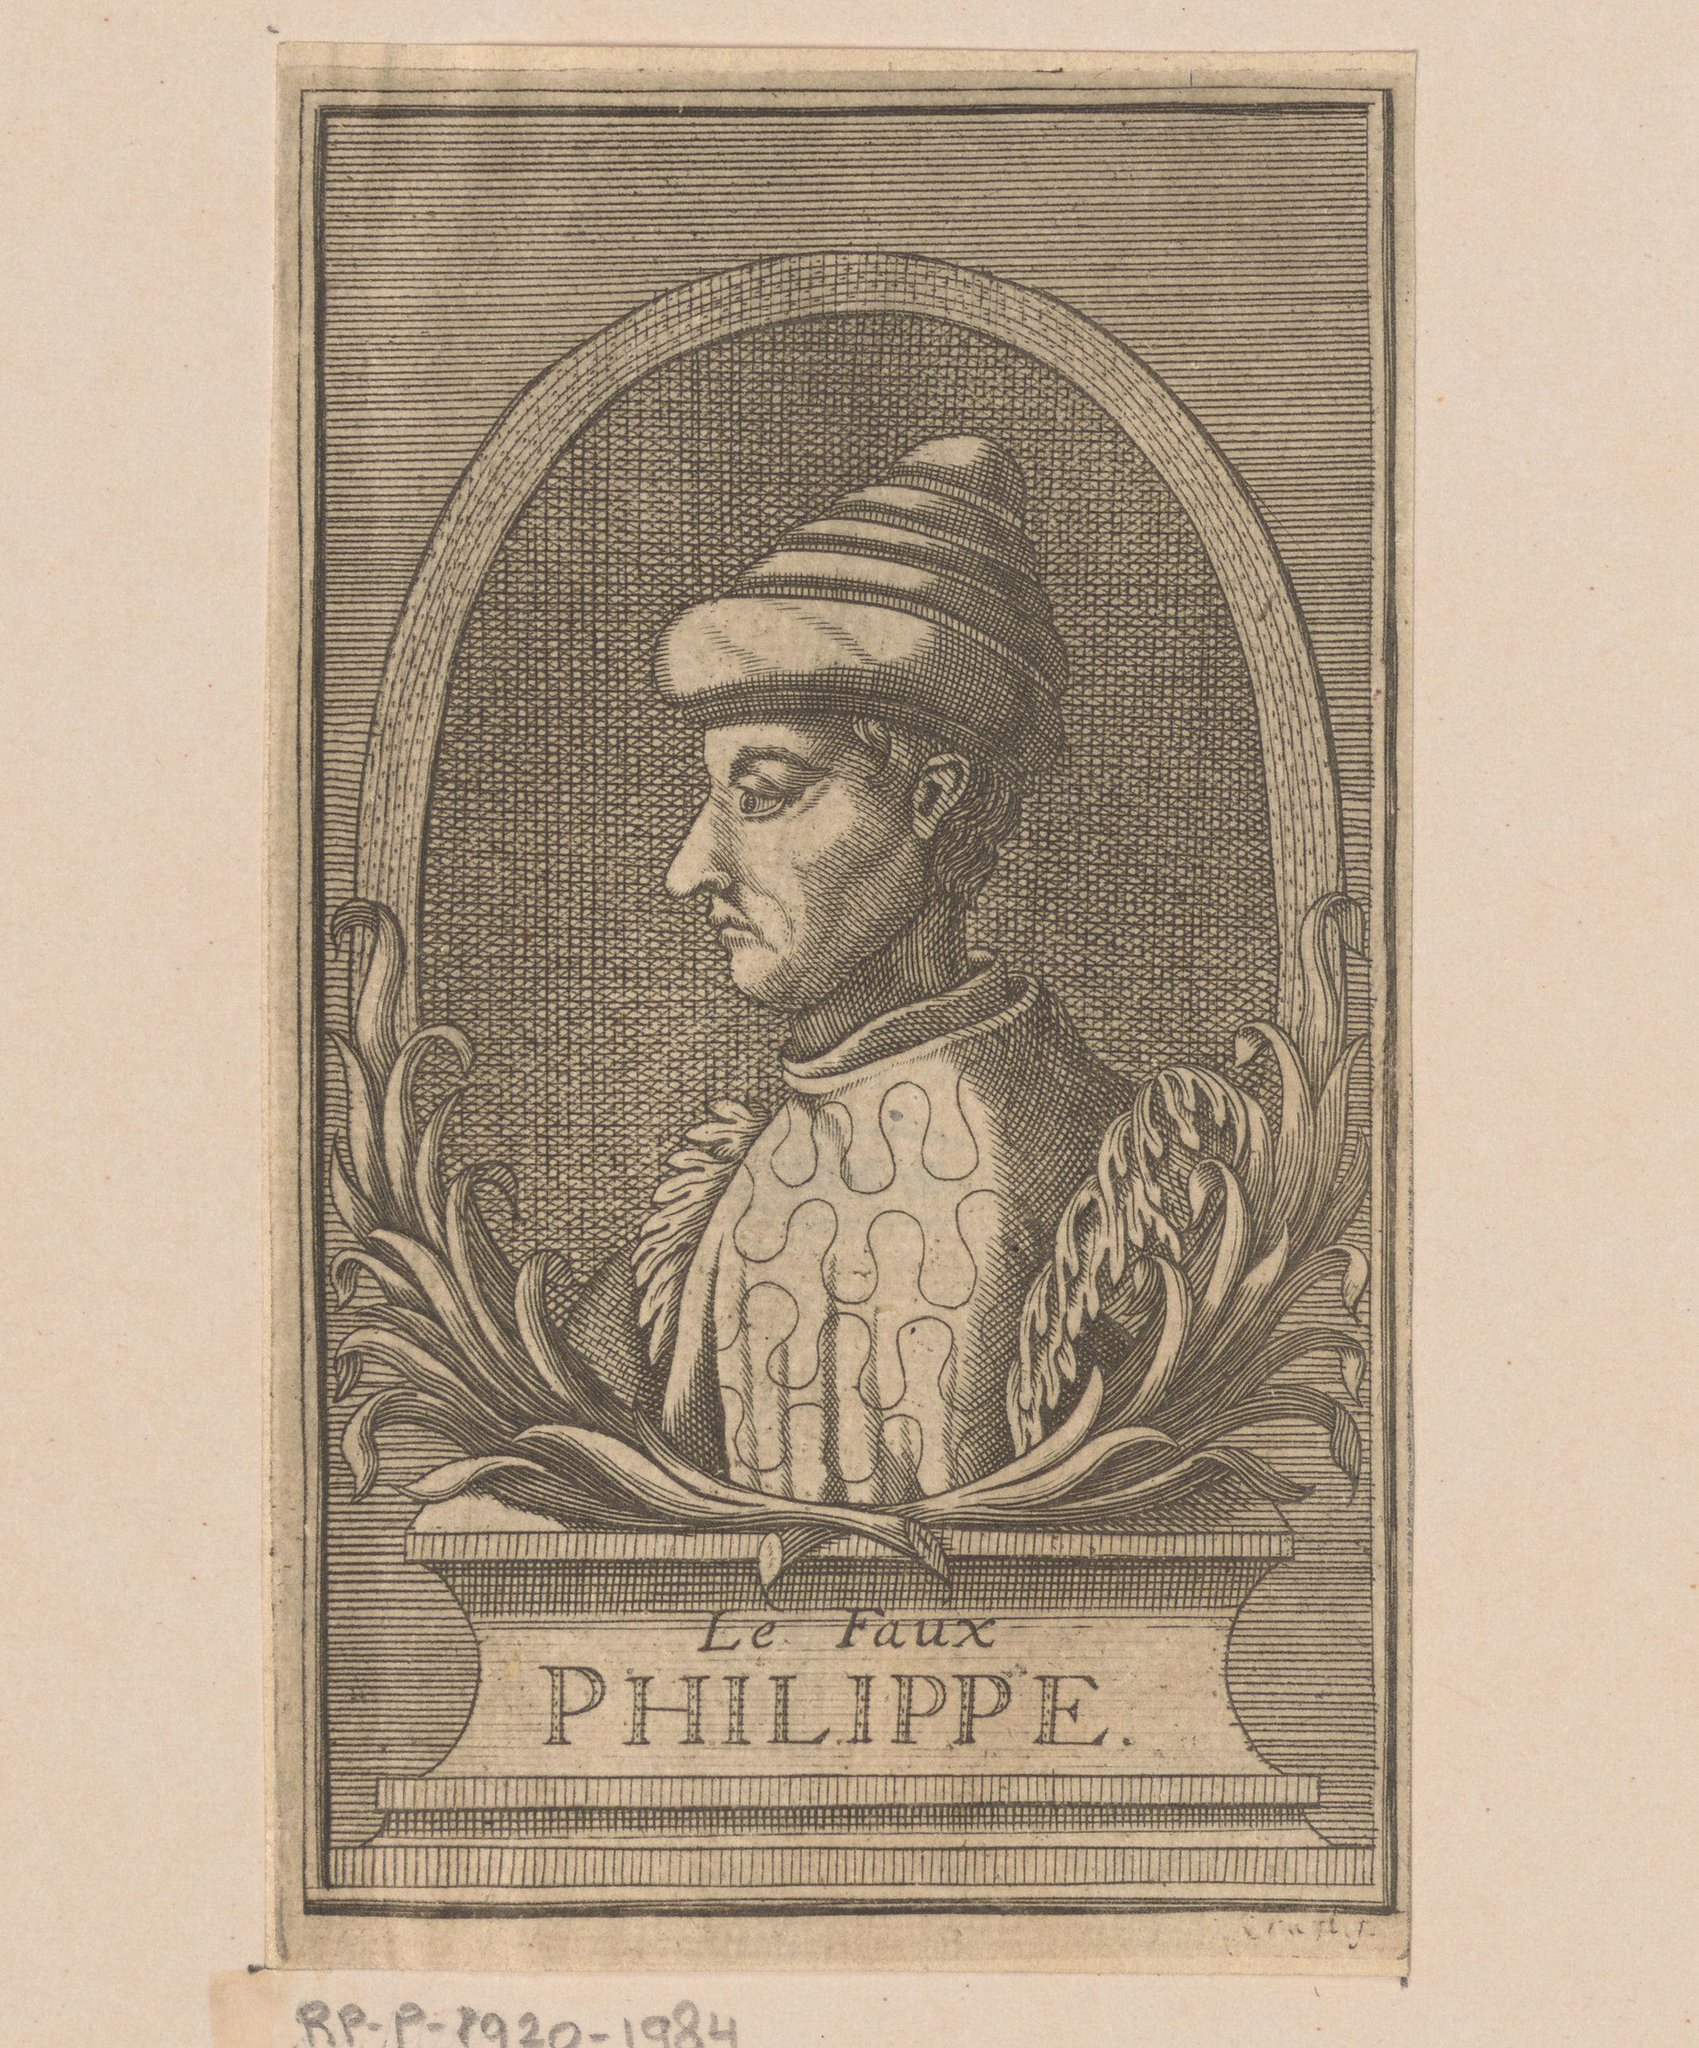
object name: book illustration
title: Portret van Andriskos (Pseudo-Philippus), koning van Macedonië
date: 1728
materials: paper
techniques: engraving, etching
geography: brussels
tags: historical persons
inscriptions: collector's mark: Lugt 2228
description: Prent uit: Rocoles, Jean Baptiste de. Les imposteurs insignes, (...). Brussel: Jean van Vlaenderen, 1728, dl. 1, p. 44.